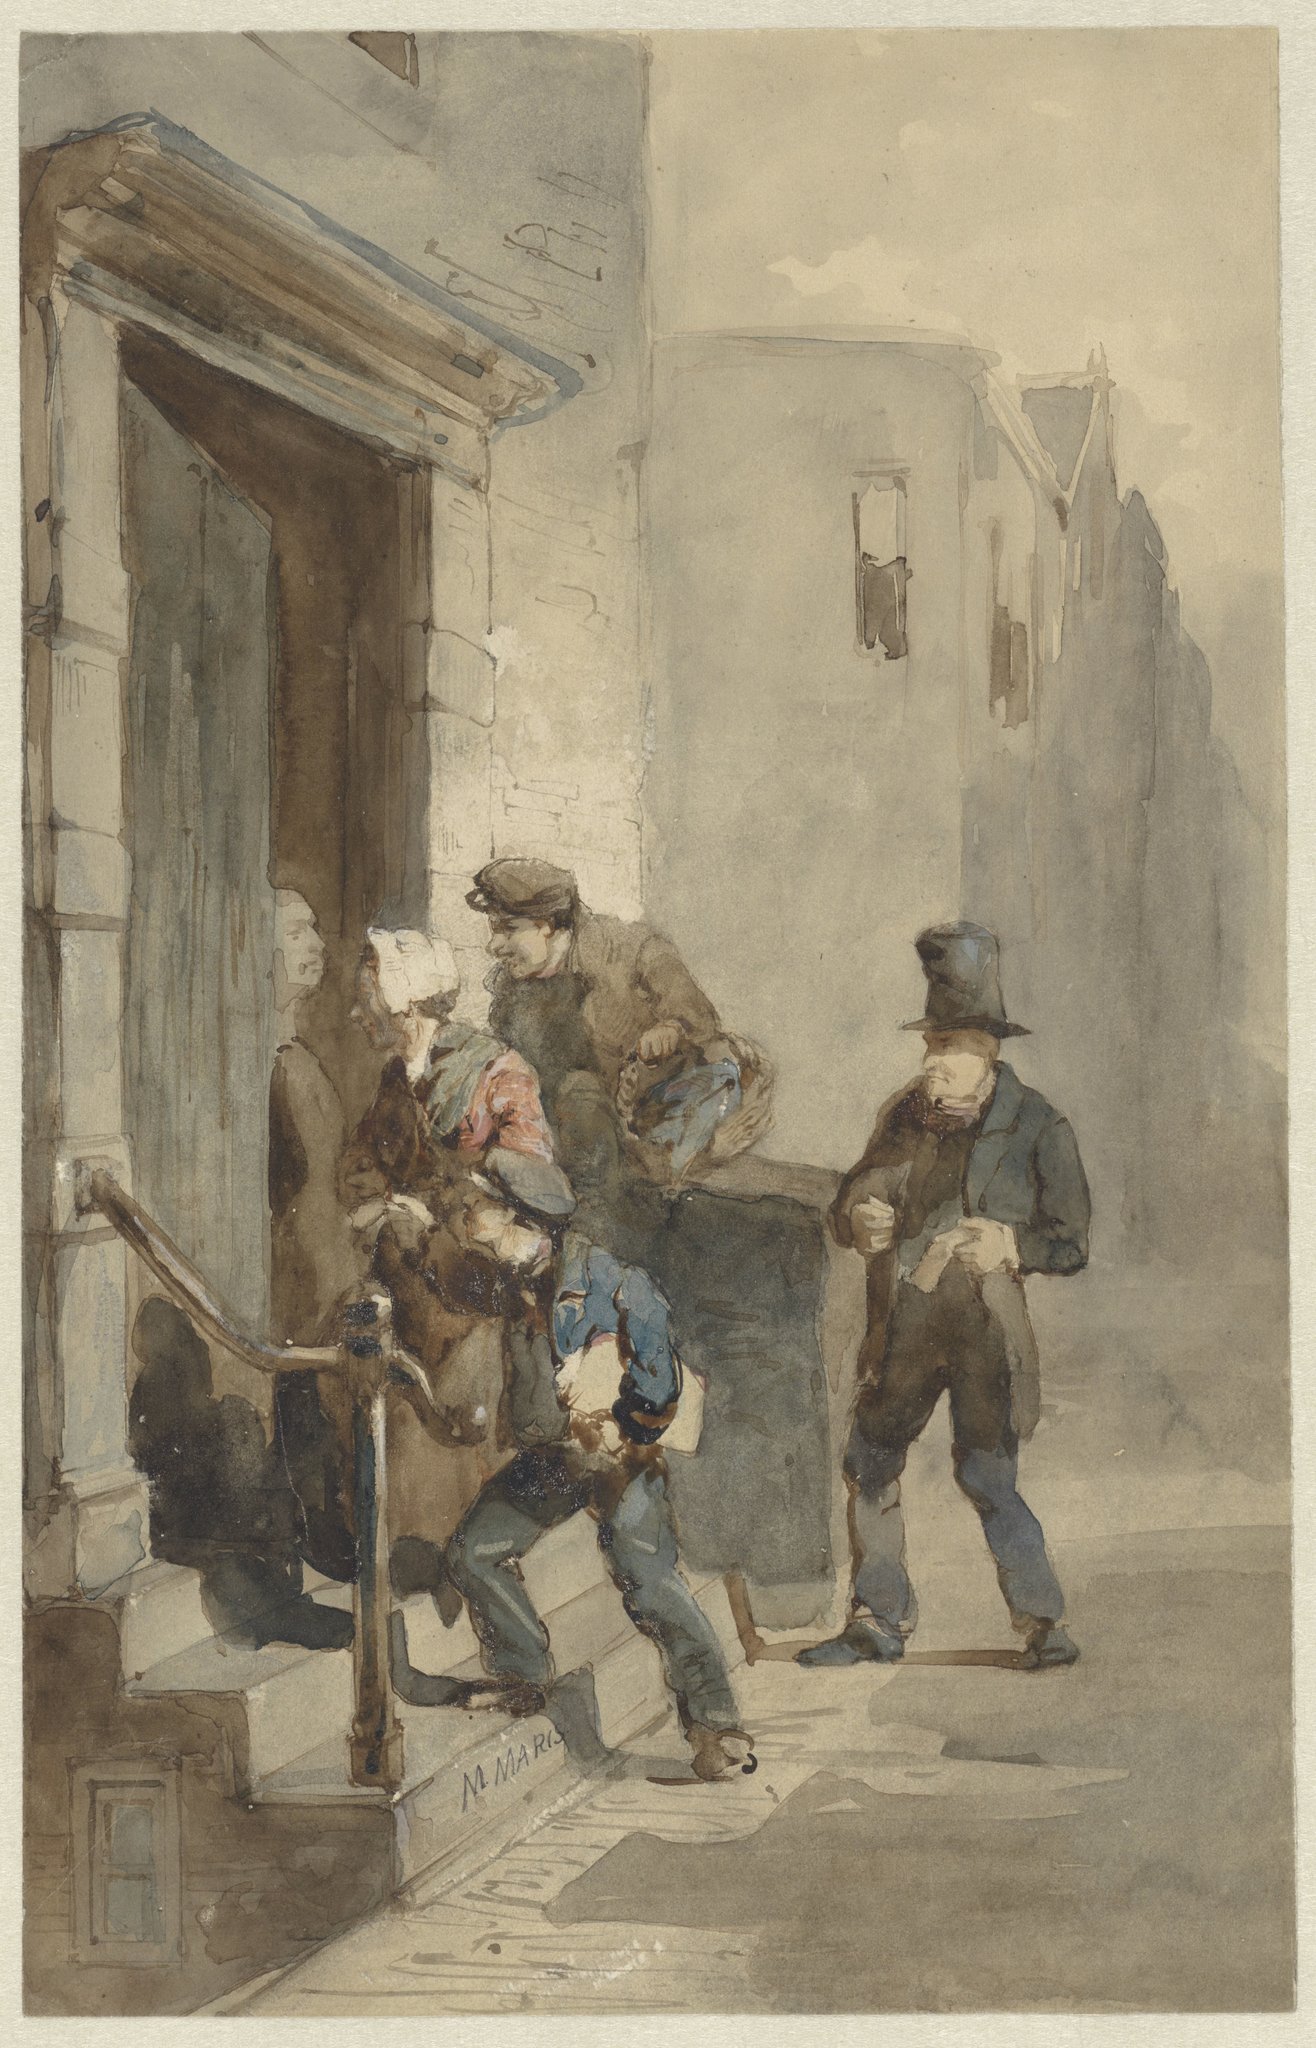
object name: drawing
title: The Creditors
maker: matthijs maris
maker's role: draughtsman, painter, print maker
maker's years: 1839-1917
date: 1855-1856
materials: ink, paper, pencil, watercolor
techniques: brush, pen